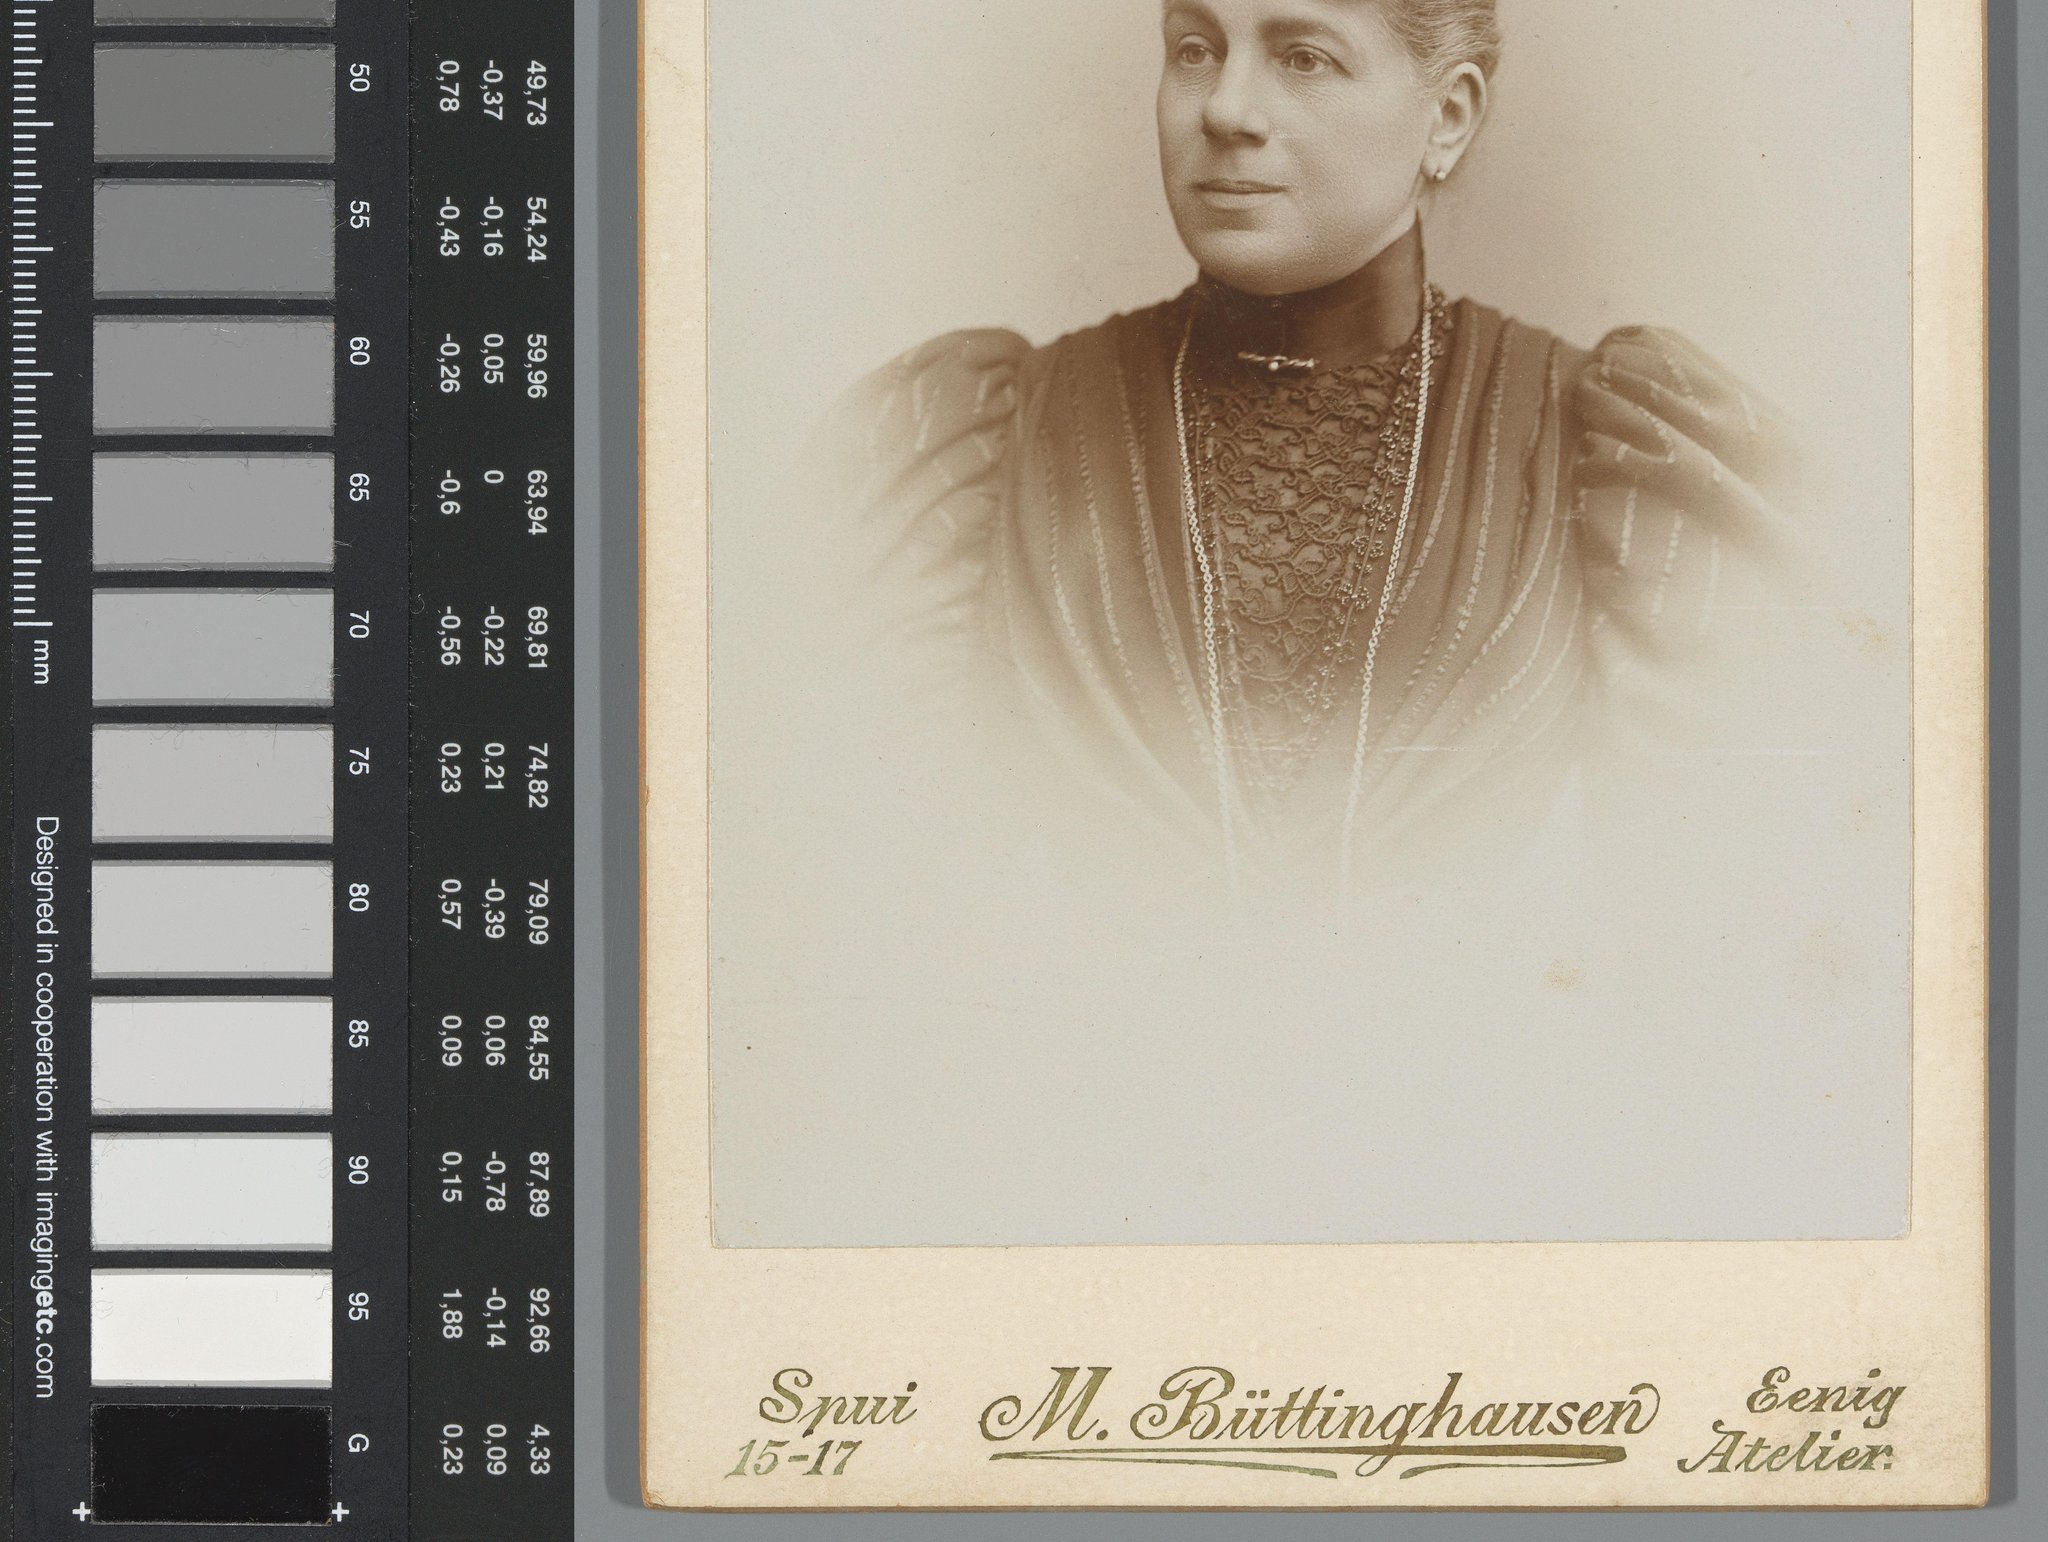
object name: cabinet photograph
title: Portret van Carolina Frederika Holle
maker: max büttinghausen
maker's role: fotograaf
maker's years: 1847-1906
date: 1870-1900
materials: cardboard, photographic support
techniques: albumen print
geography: spui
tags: amsterdam, carolina frederika van den berg-holle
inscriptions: inscription: ‘Spui / 15 - 17 / M. Büttinghausen / Eenig / Atelier.’